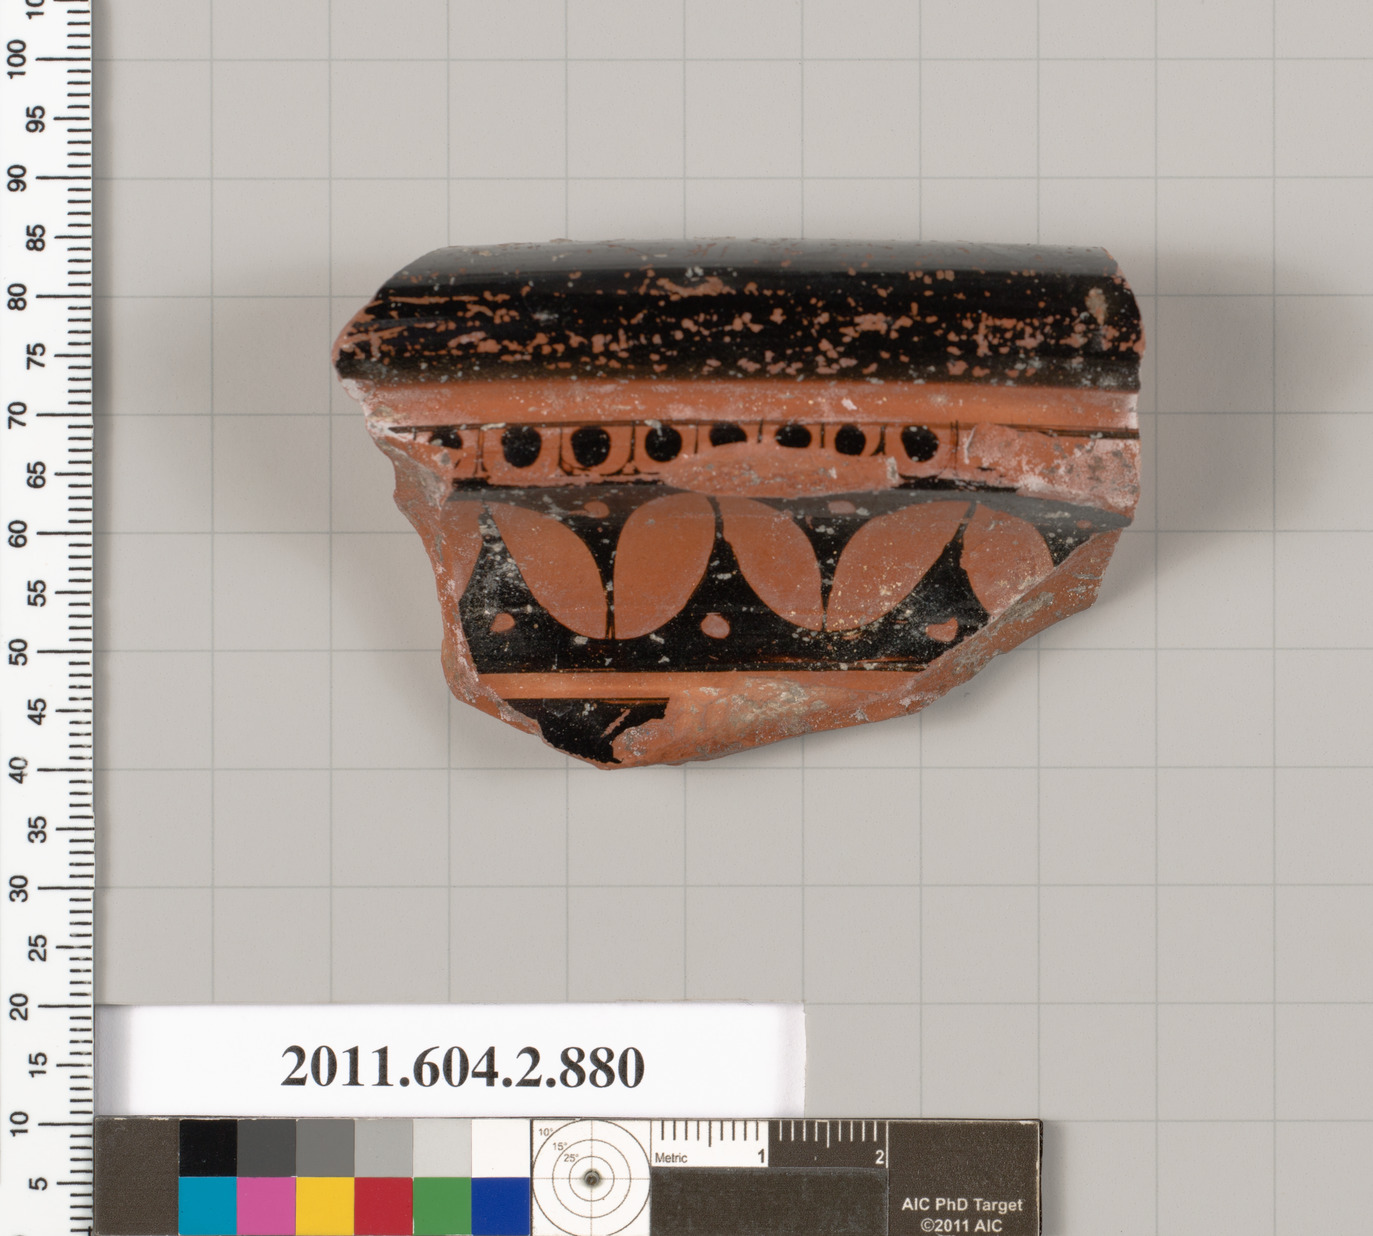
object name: bell krater fragment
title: Terracotta fragment of a bell-krater (bowl for mixing wine and water)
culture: greek, attic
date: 440 BCE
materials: terracotta